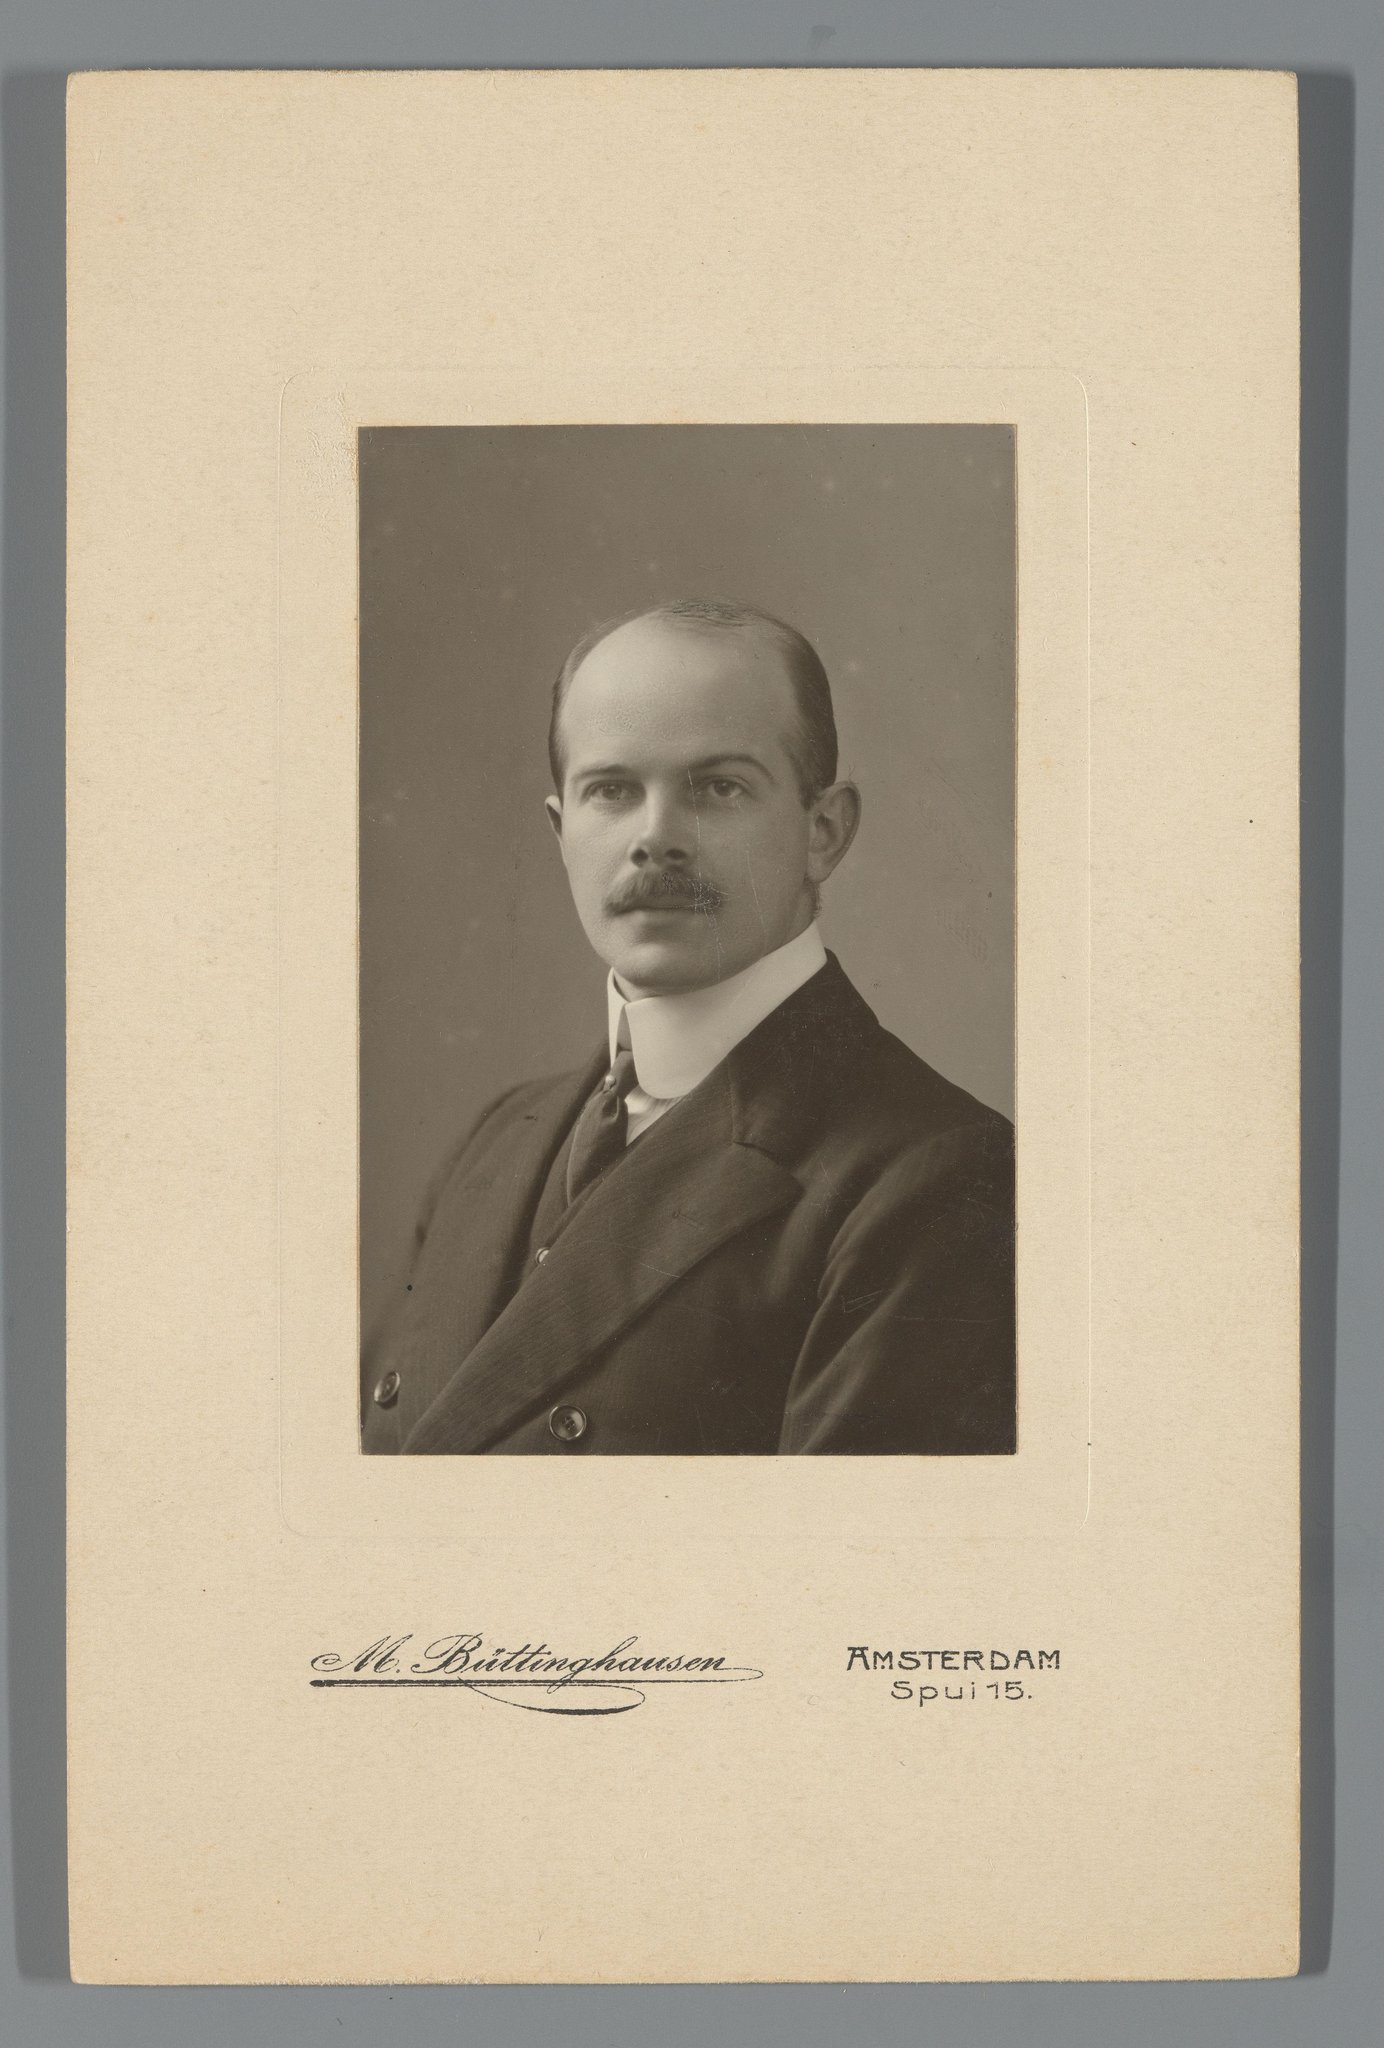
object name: cabinet photograph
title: Portret van Hendrik Herman van den Berg (Henk)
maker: max büttinghausen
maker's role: fotograaf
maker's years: 1847-1906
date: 1898-1910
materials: cardboard, photographic support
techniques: albumen print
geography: spui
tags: hendrik herman van den berg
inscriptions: inscription: ‘M. Büttinghausen AMSTERDAM / Spui 15.’